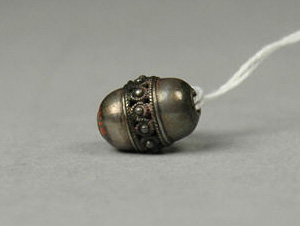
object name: ojime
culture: japanese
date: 1801-1900